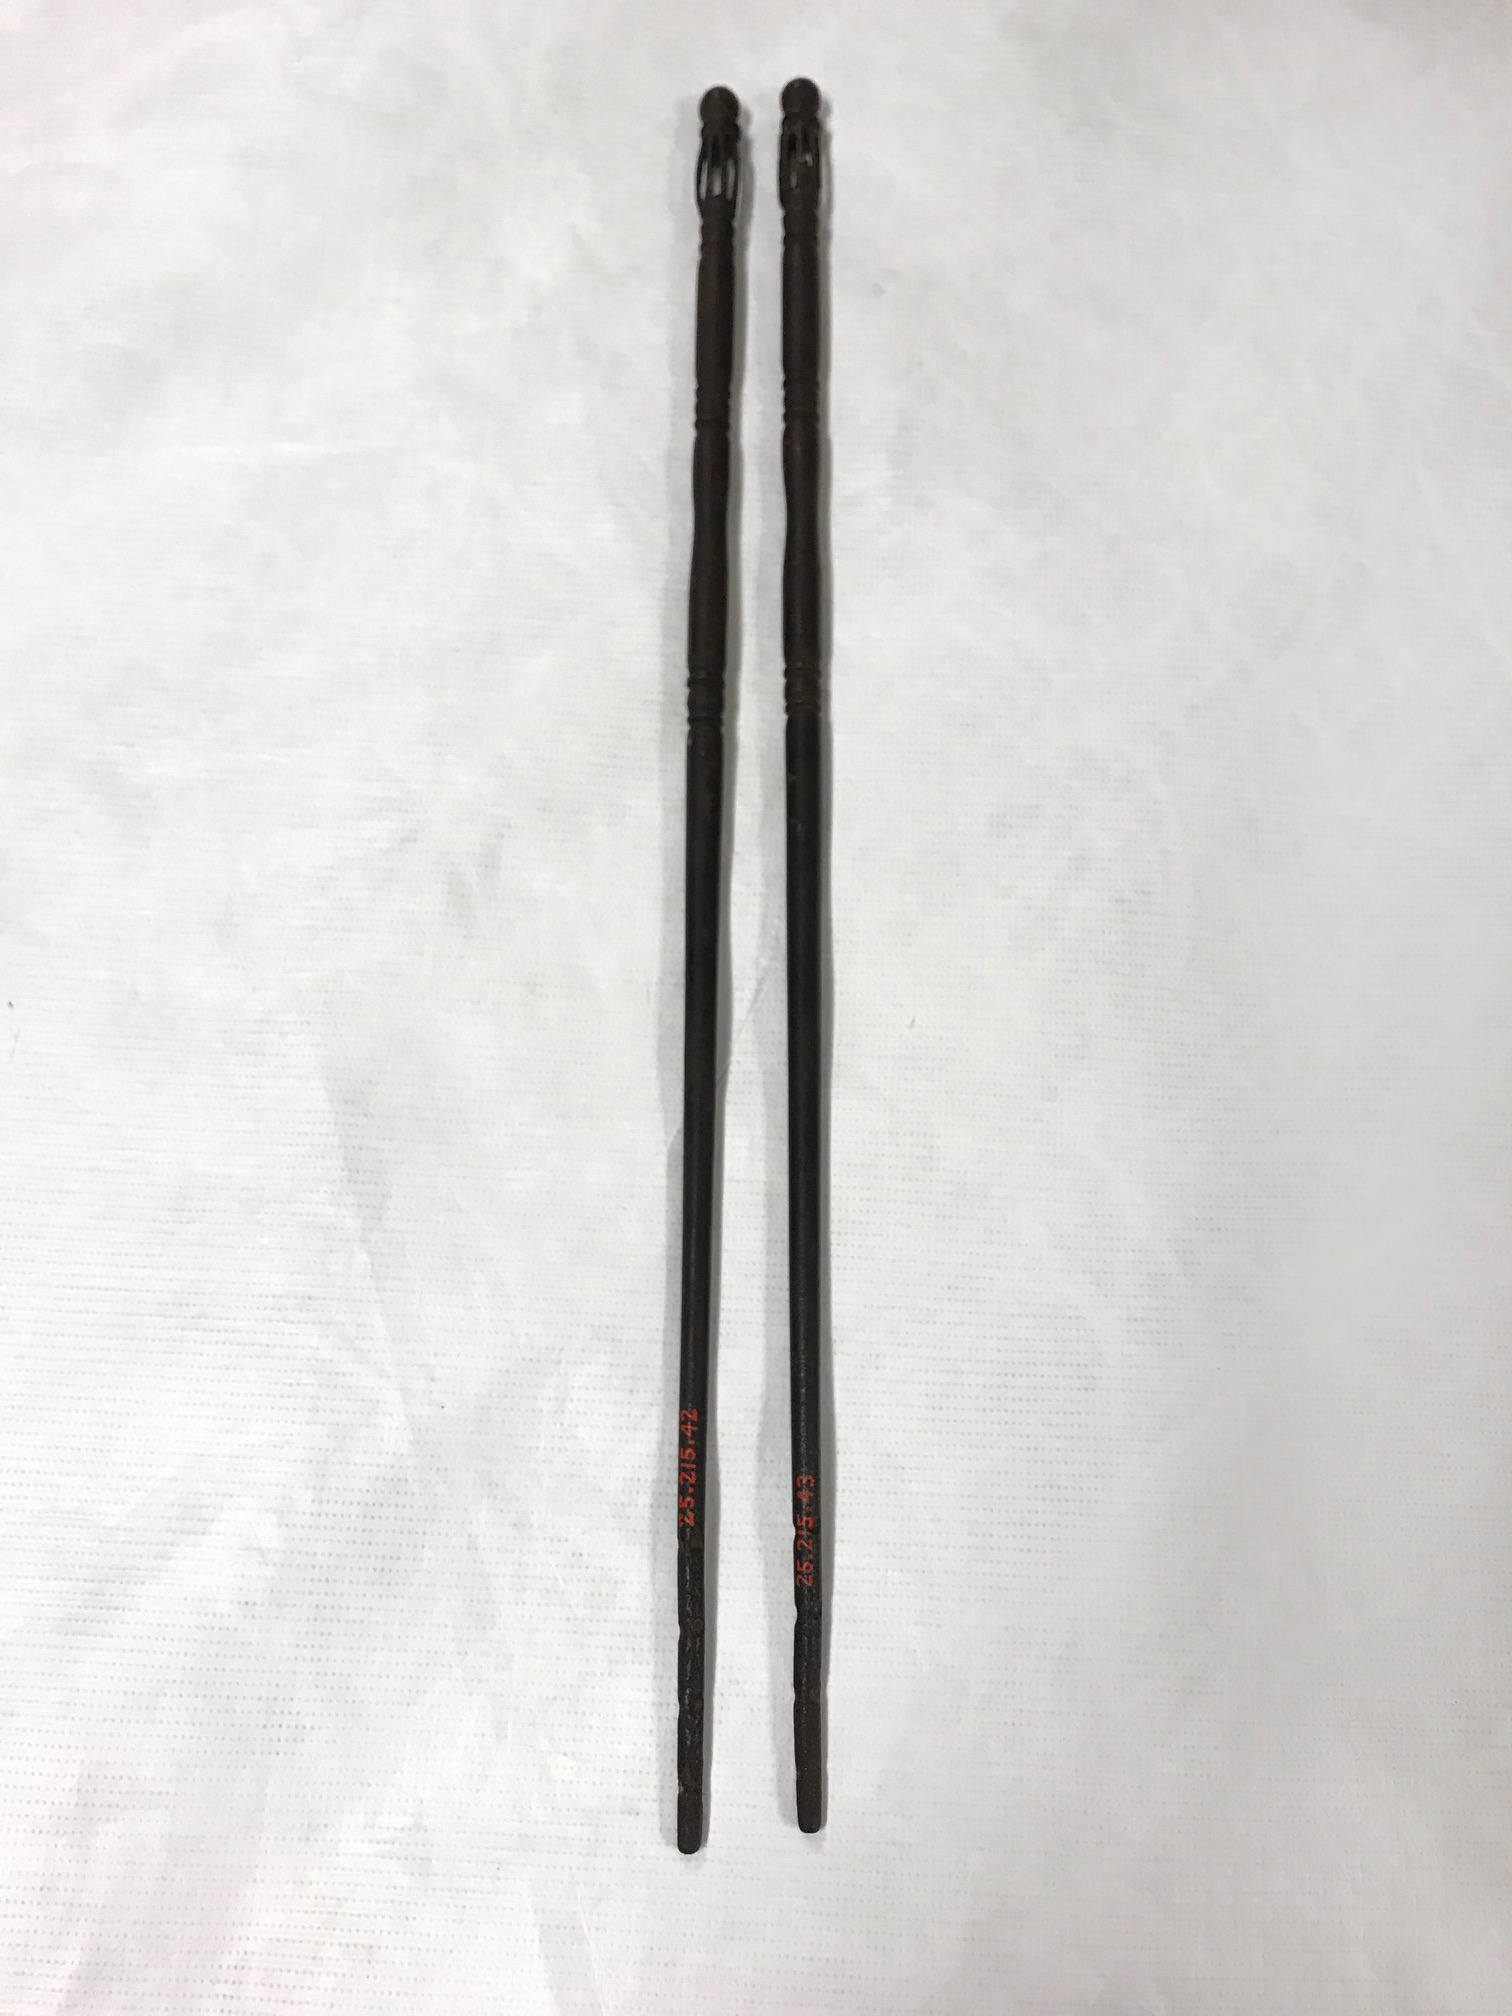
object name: fire tong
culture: japanese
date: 1775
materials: iron